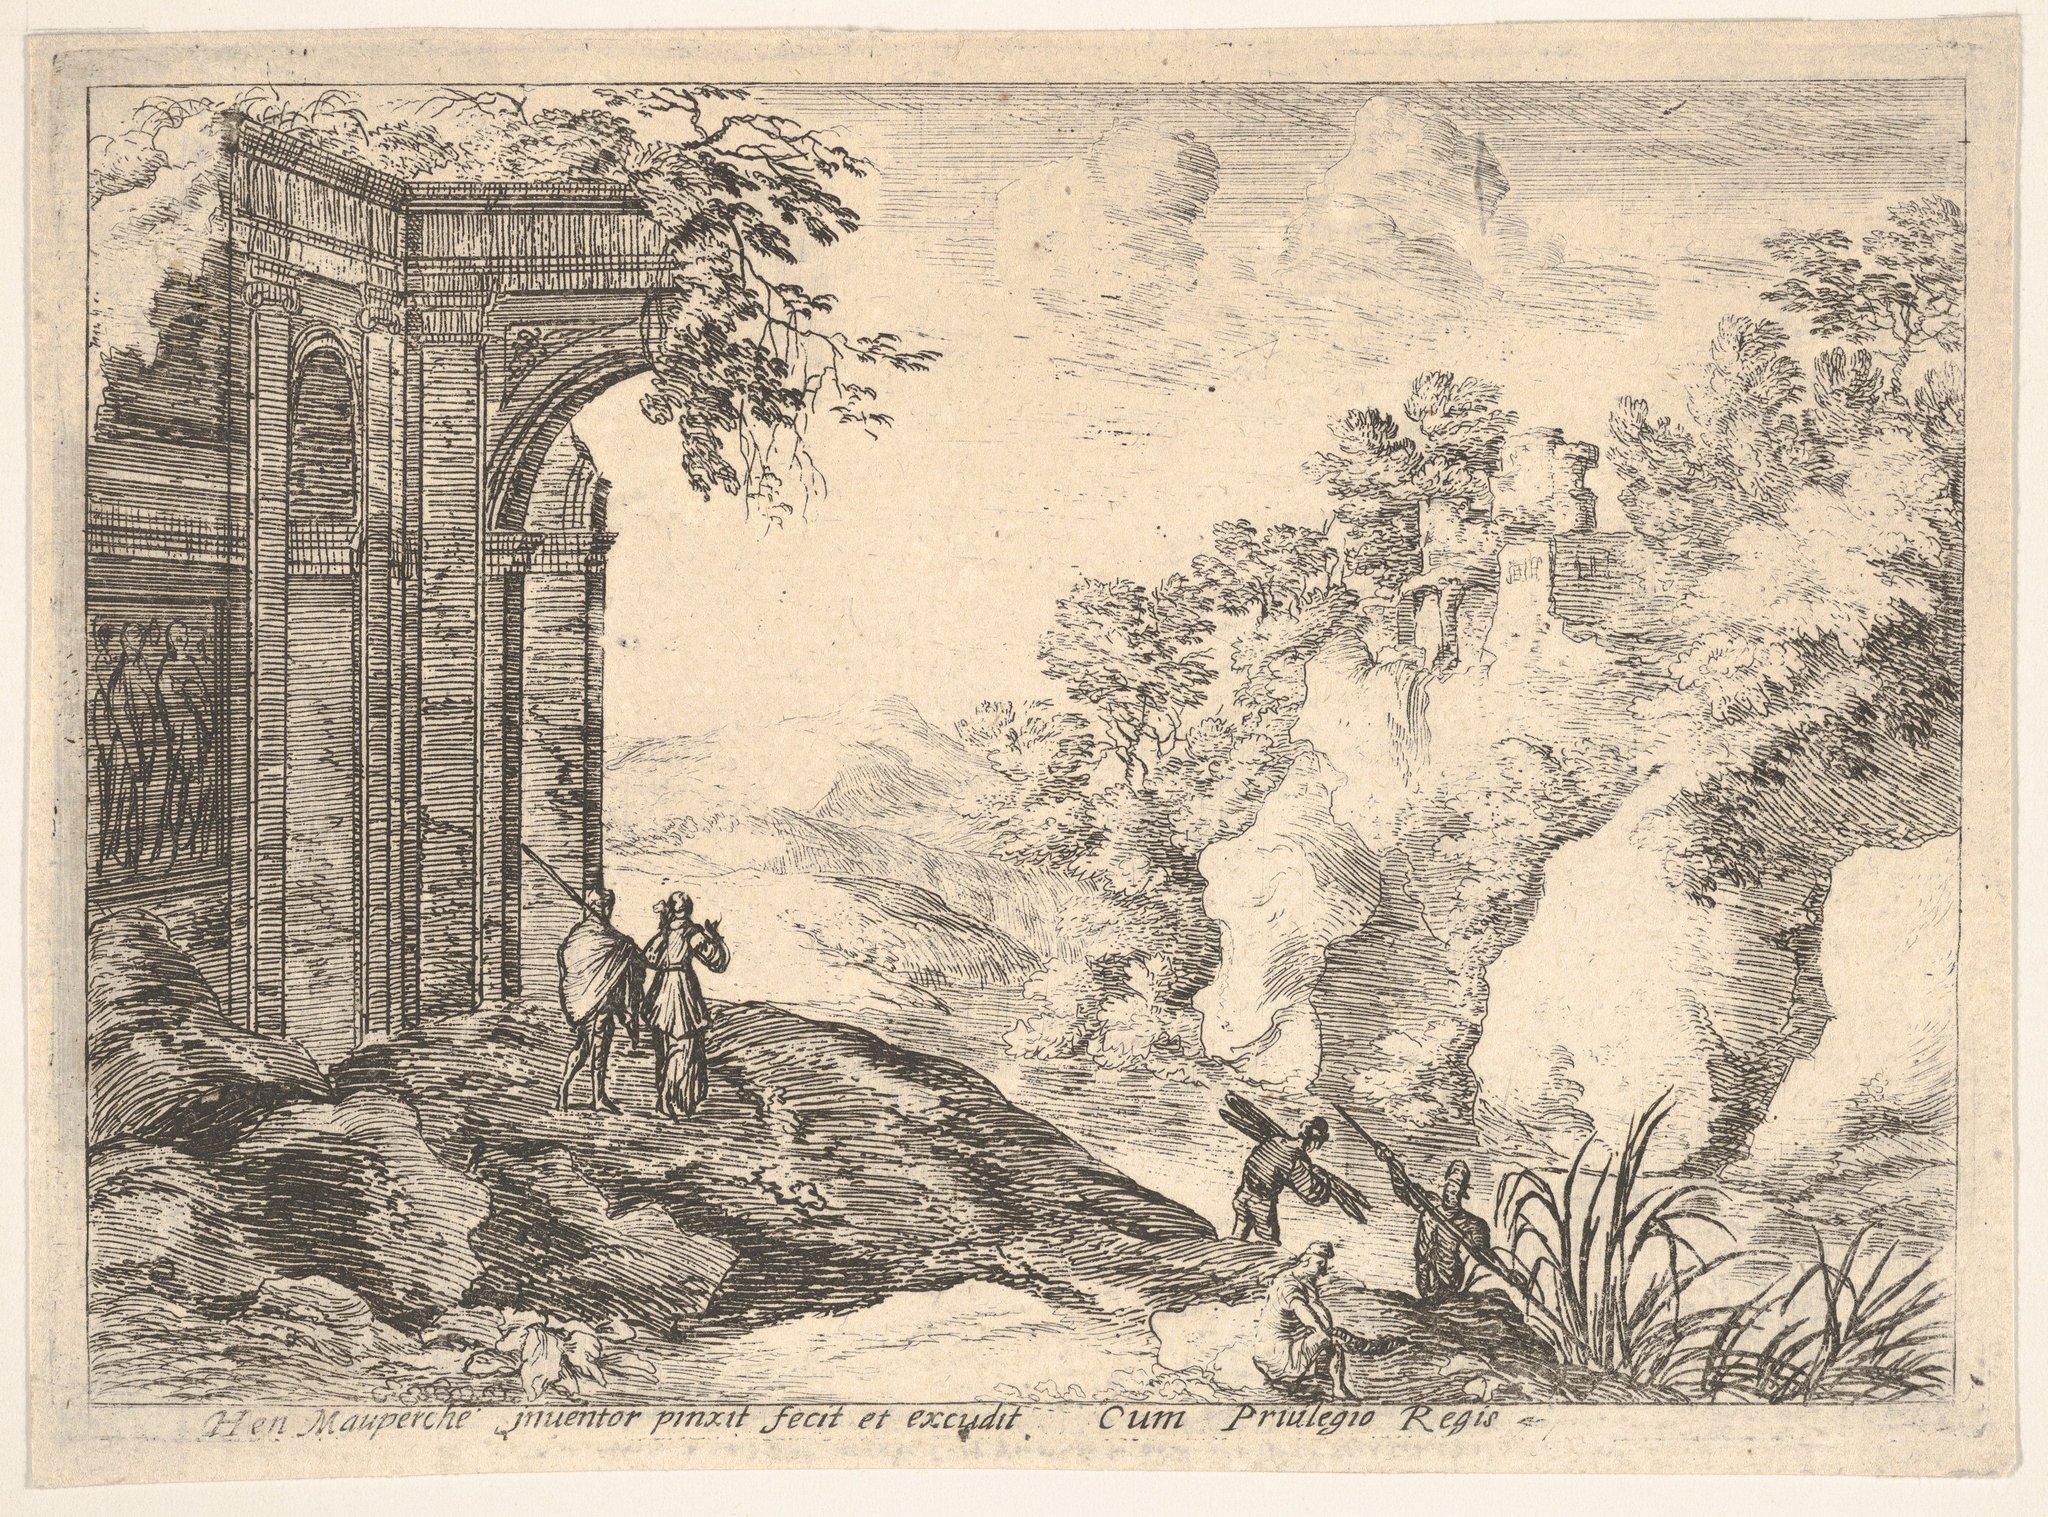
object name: print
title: Le Pan de Muraille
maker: henri mauperché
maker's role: artist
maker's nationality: french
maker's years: 1602-1686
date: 1601-1700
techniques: etching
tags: ruins,men,working